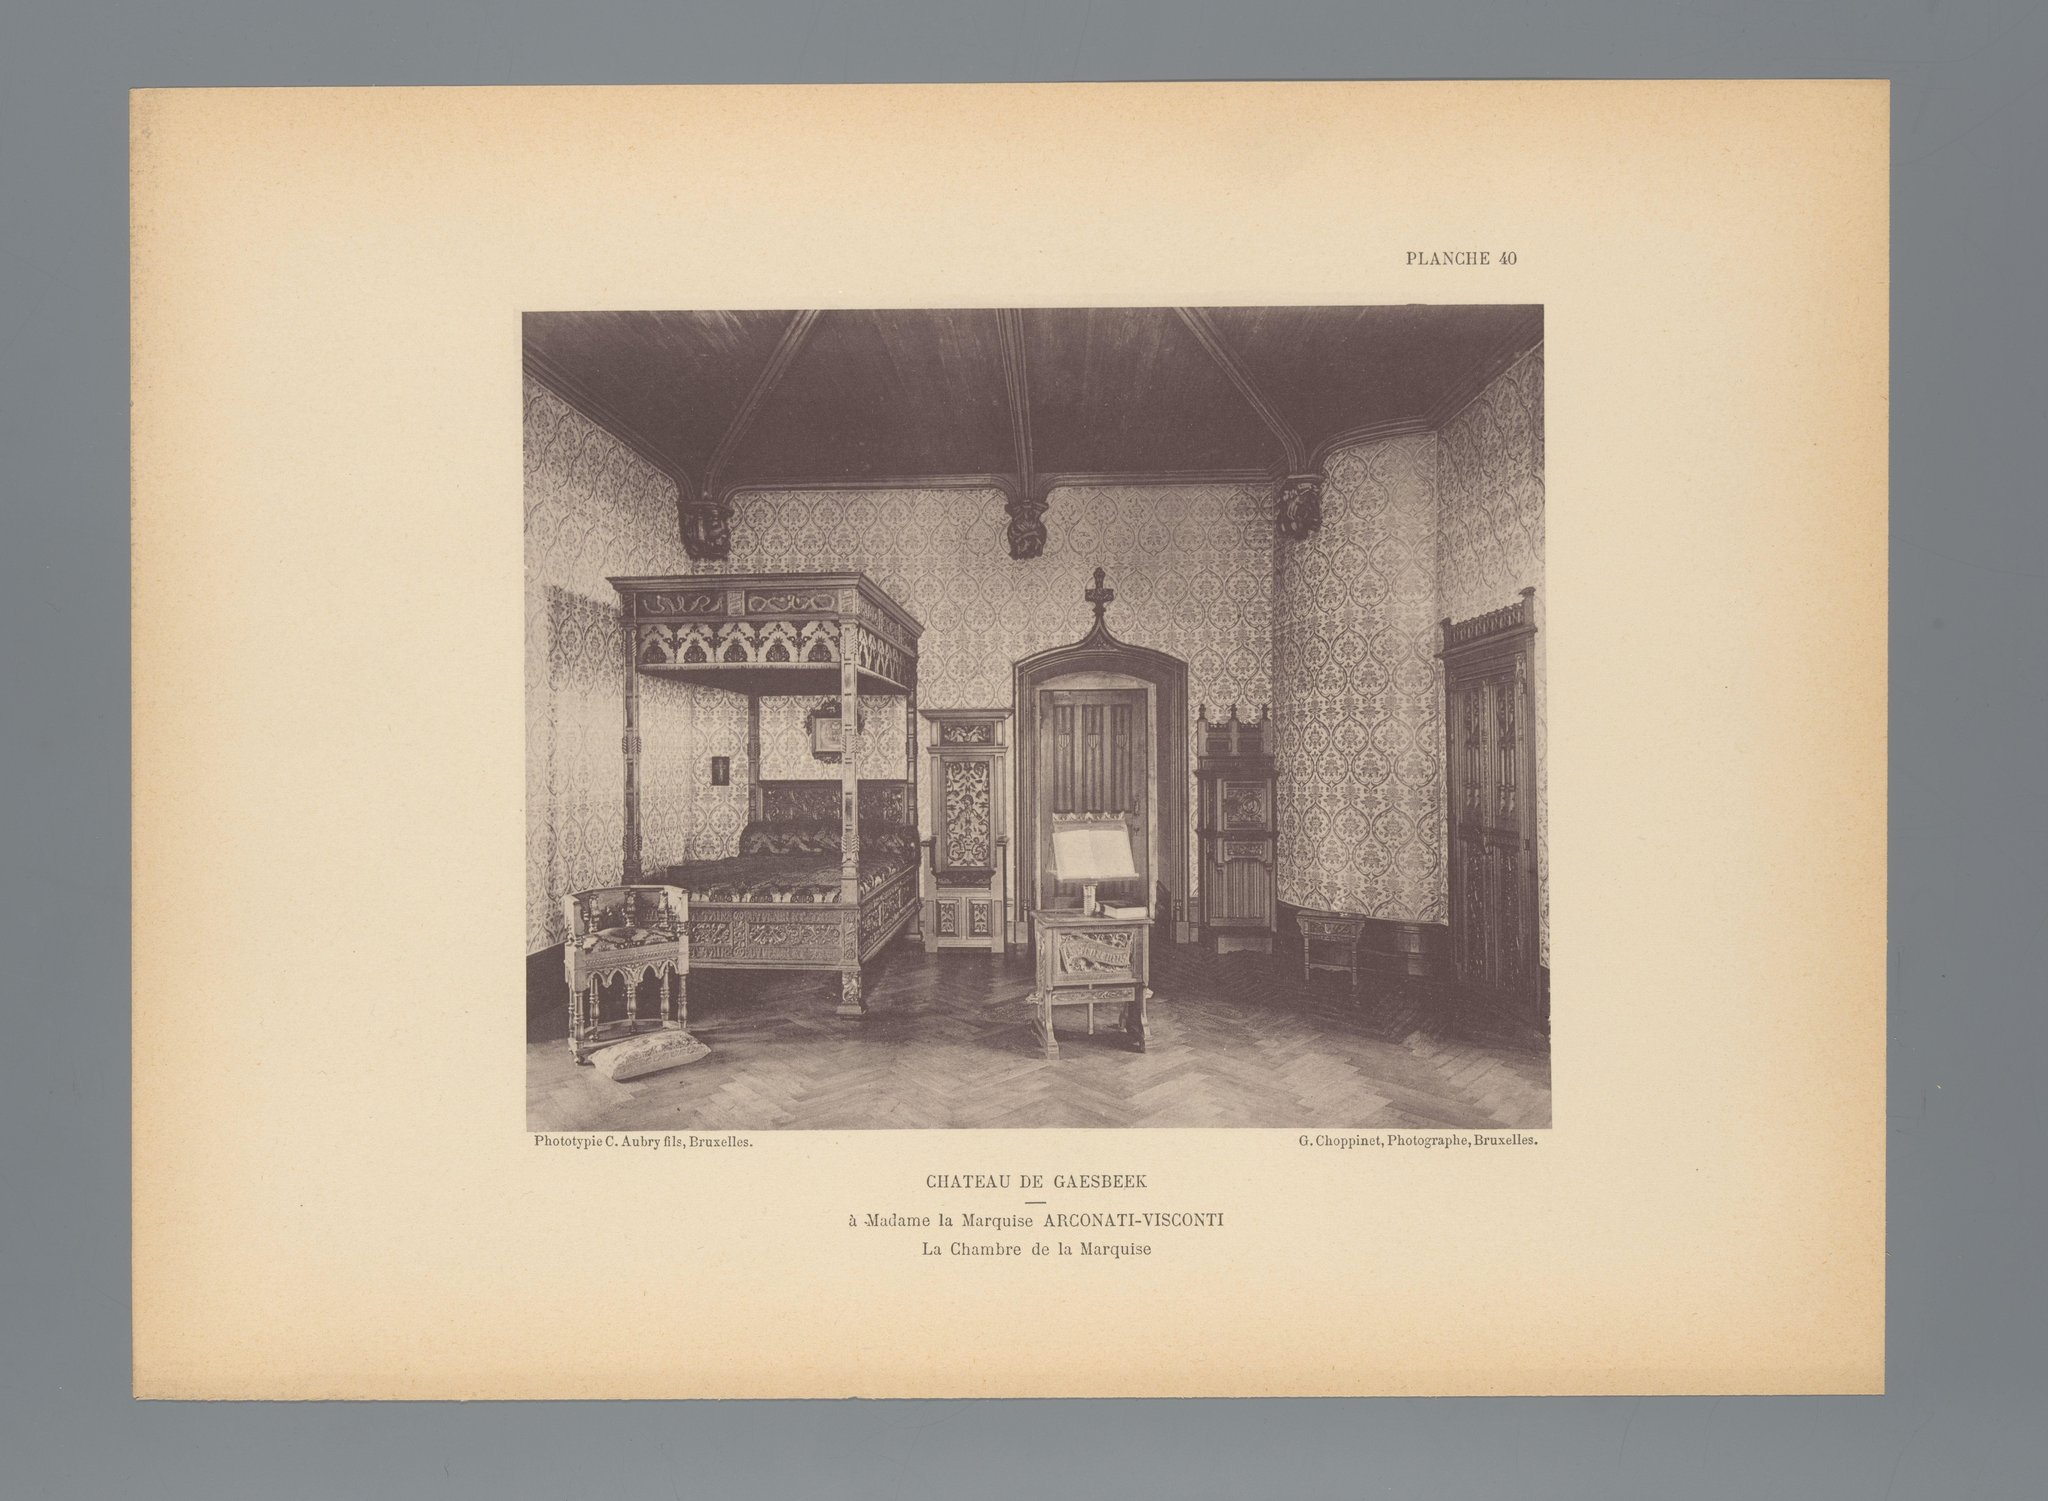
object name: photomechanical print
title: Gezicht op de slaapkamer van Paul Arconati-Visconti in het Kasteel van Gaasbeek, België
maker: gustave choppinet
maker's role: fotograaf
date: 1893-1898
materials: paper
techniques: photograph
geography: kasteel van gaasbeek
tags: castle, bedroom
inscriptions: number: ‘PLANCHE 40’, inscription: ‘à Madame la Marquise ARCONATI-VISCONTI/ La Chambre de la Marquise’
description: Deze prent maakt deel uit van een omslag met 89 prenten en 5 tekstbladen.